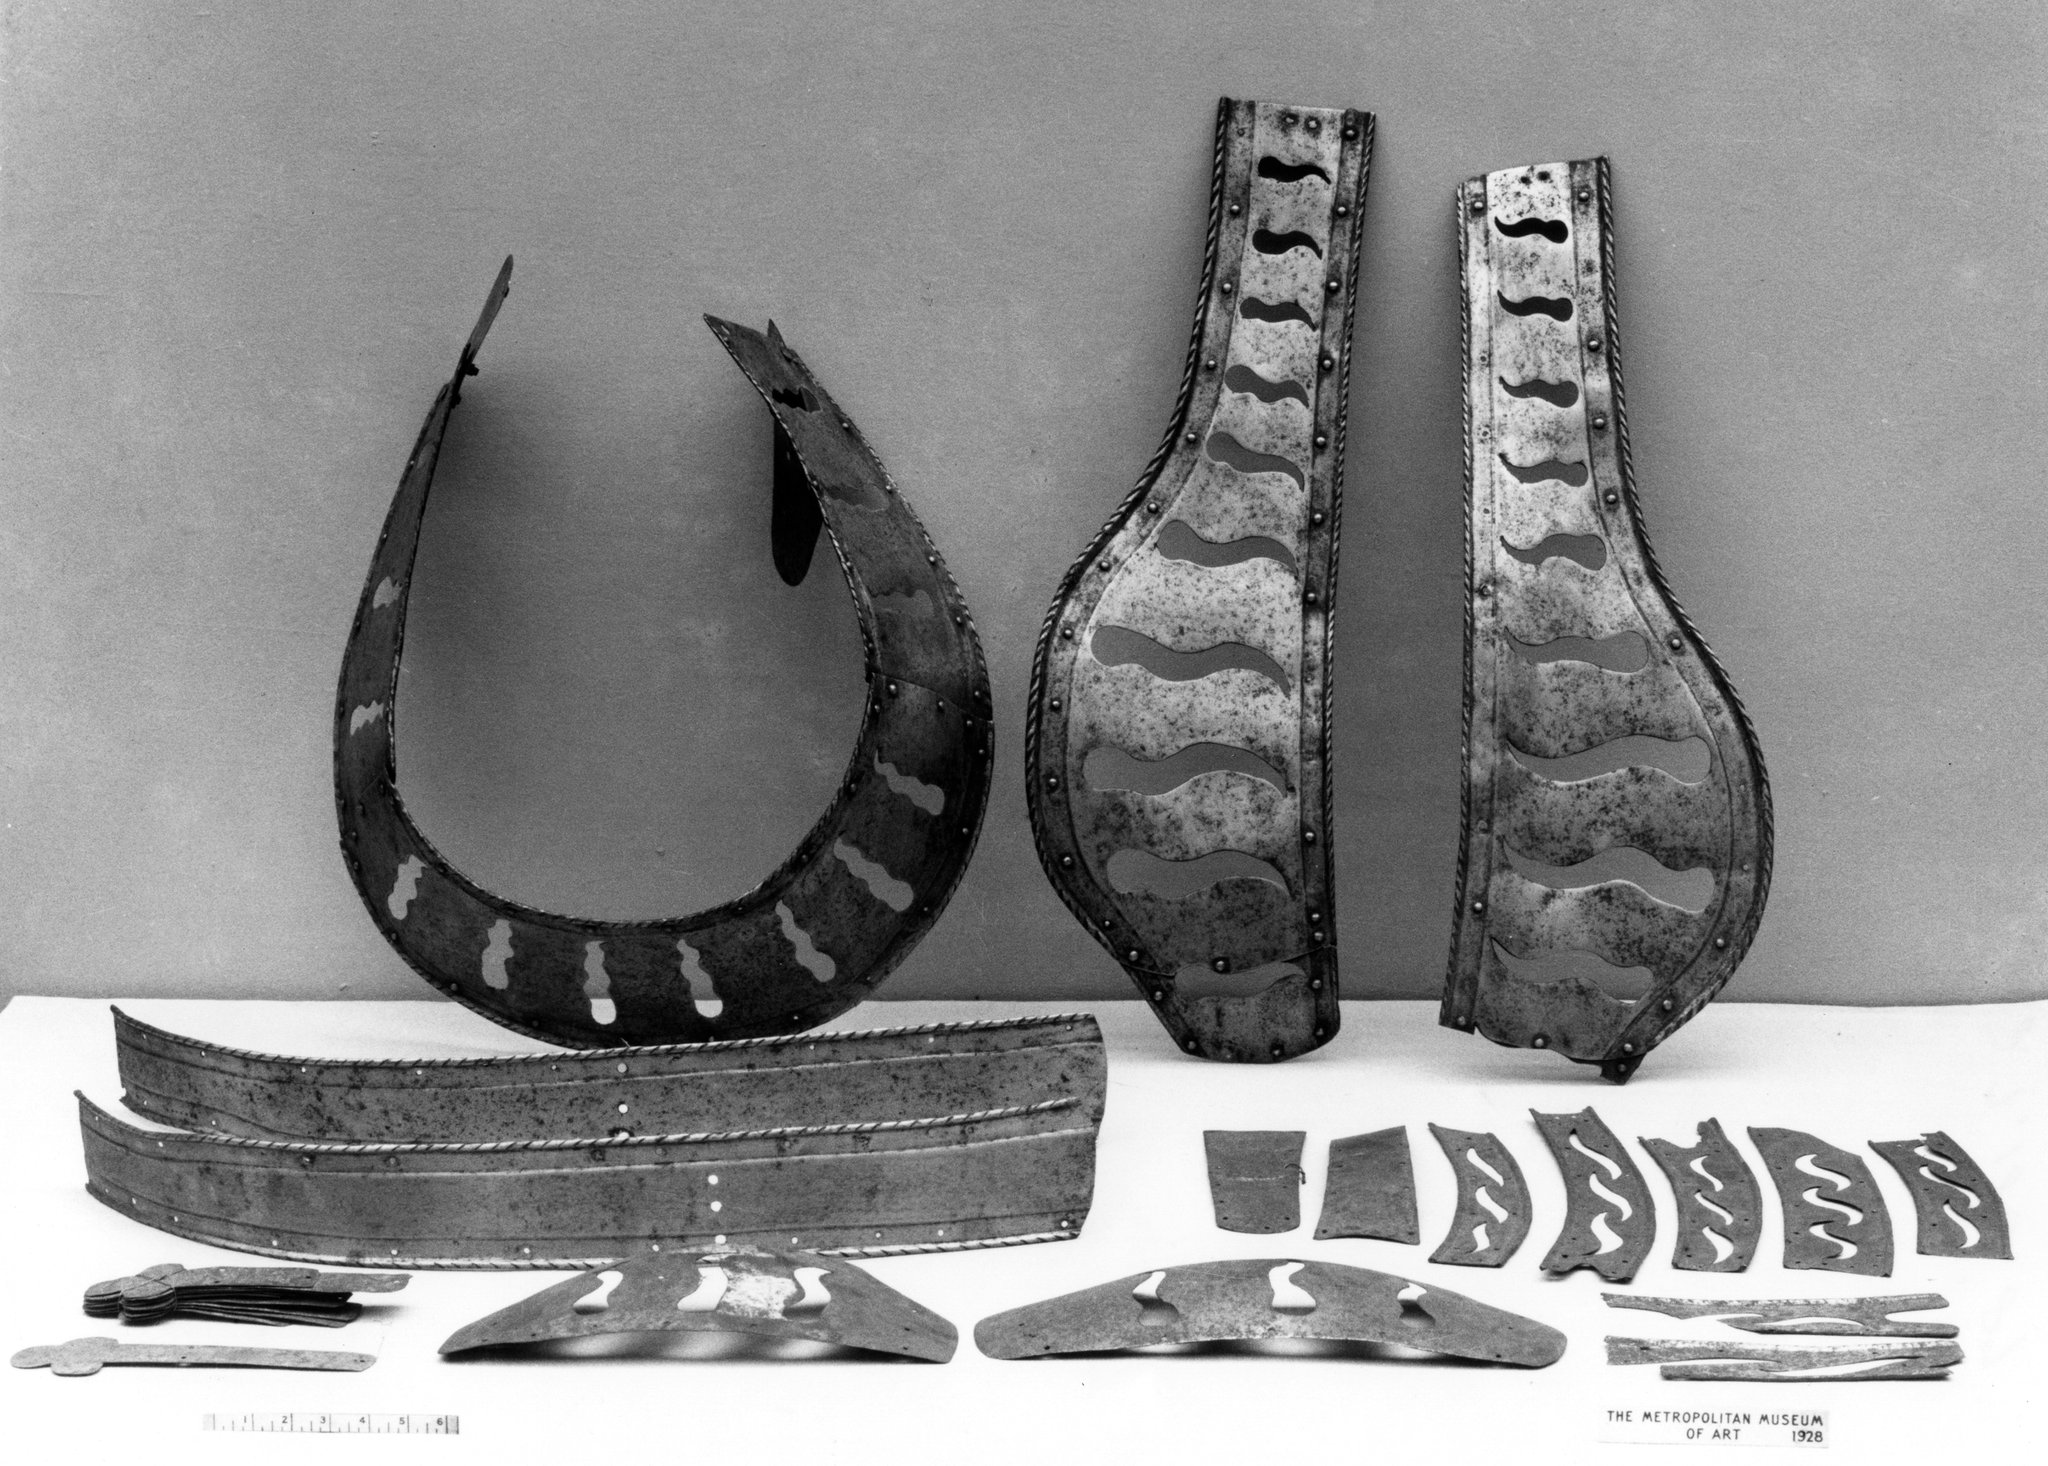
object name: horse armor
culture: german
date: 1501-1600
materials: leather, steel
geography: germany